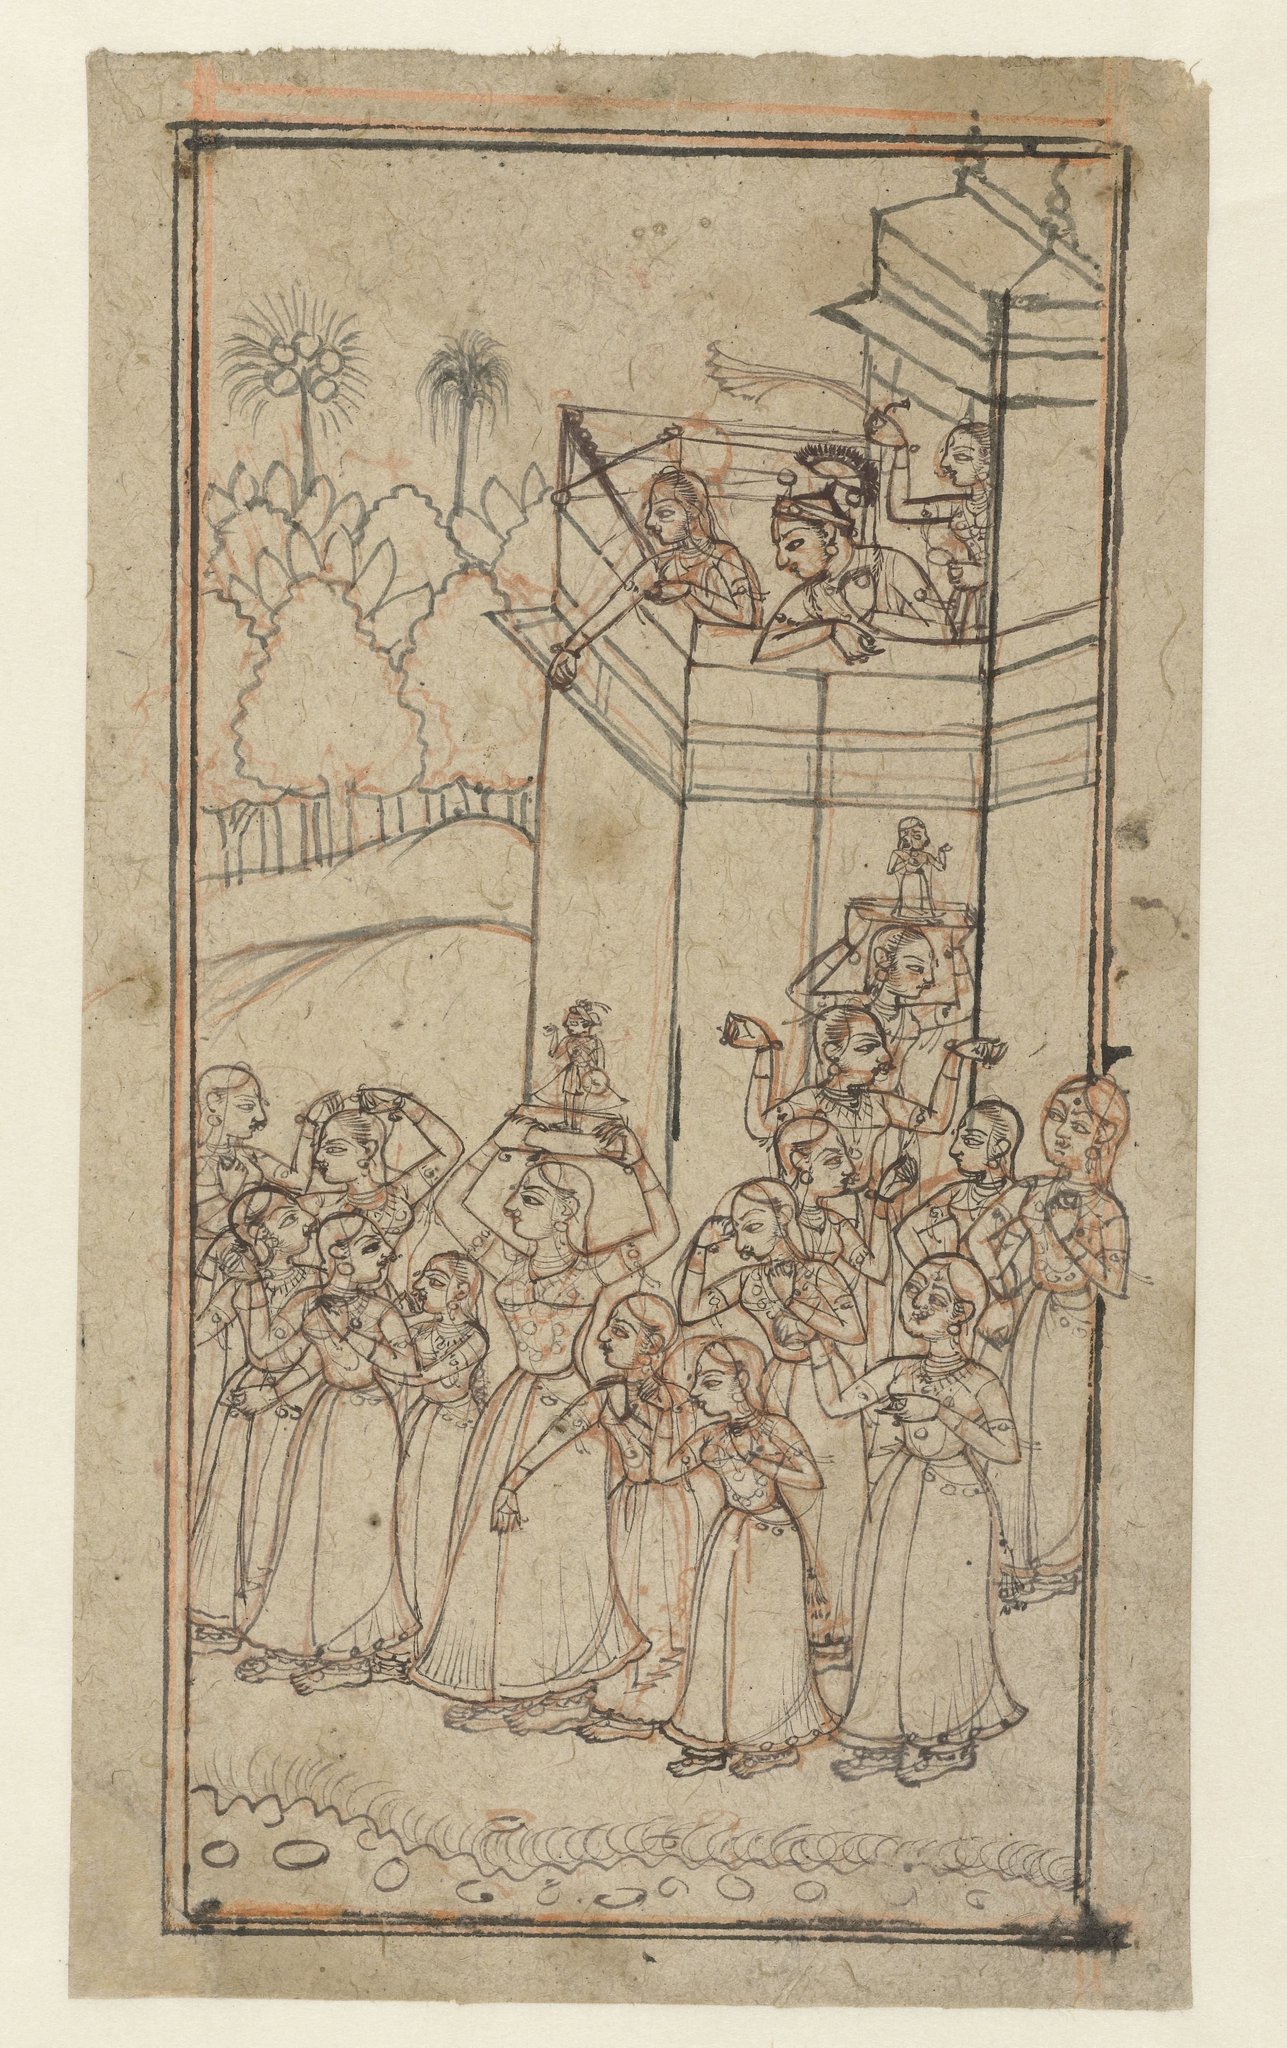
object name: indian miniature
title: Het Gangaur-feest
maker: Anonymous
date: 1795-1805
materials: ink, paper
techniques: brush, pen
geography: bundi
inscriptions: inscription: ‘.’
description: Vanaf een balkon kijken Krishna en Radha neer op een groep vrouwen in een feestelijke groep; sommigen dragen een pop op het hoofd. Zwarte kaderlijnen met stukjes overgebleven rood ingevuld.